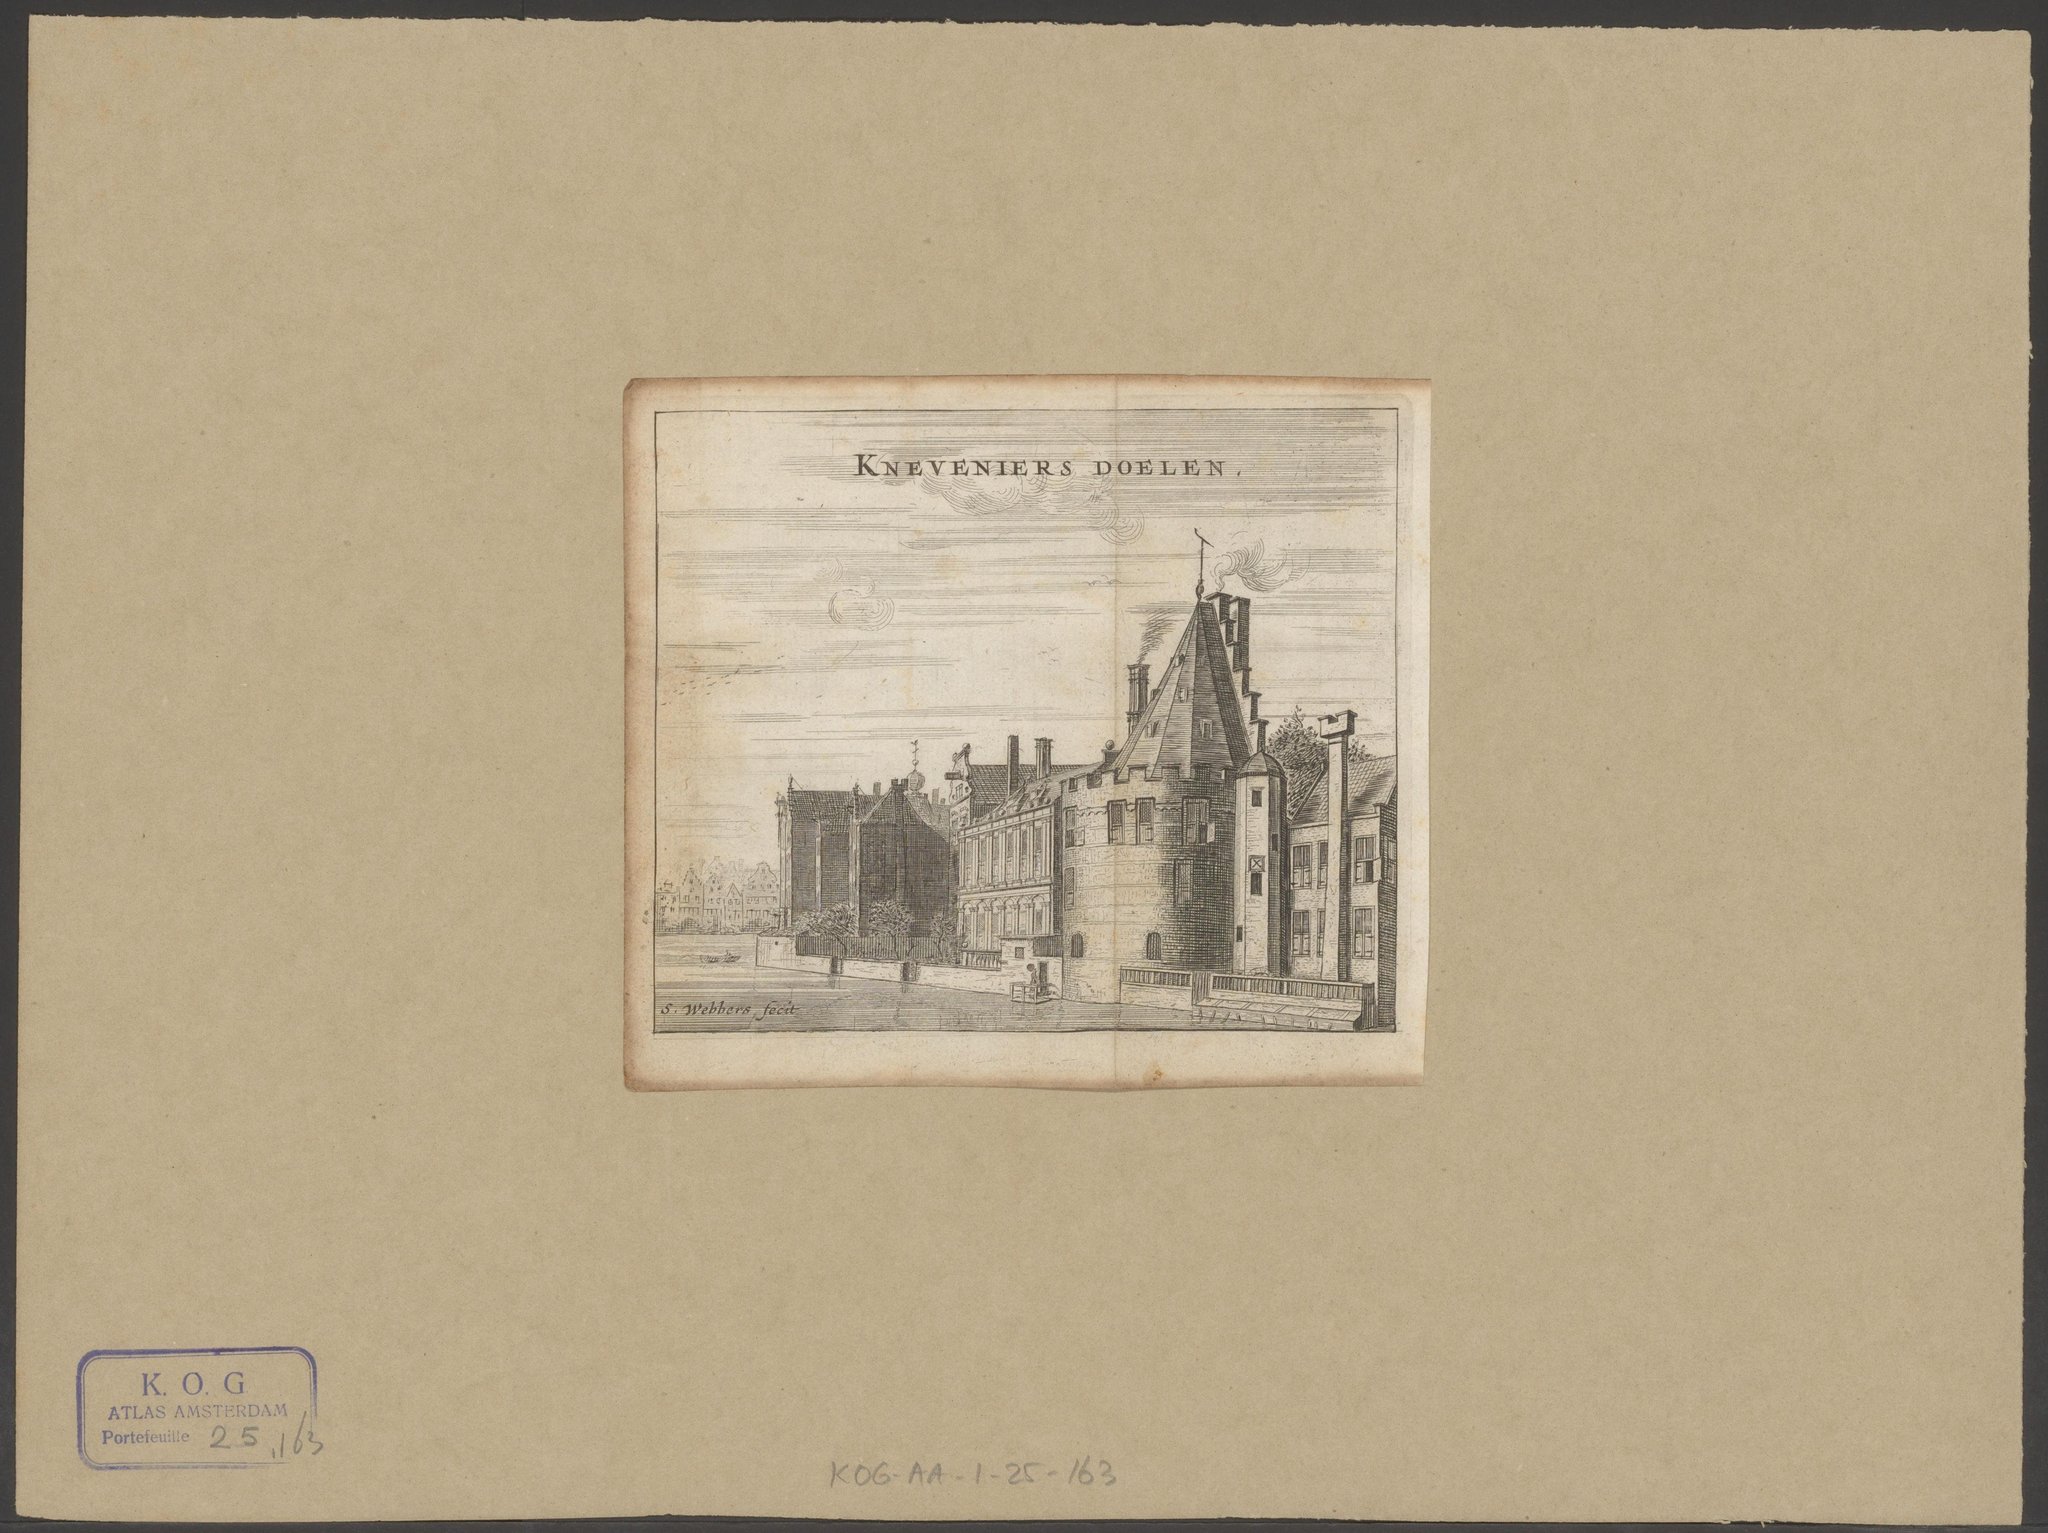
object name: book illustration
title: Kneveniers Doelen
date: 1664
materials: paper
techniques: engraving, etching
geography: amsterdam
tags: towers ~ fortified city, city-walls, land forces (+ citizen soldiery, civil guard, citizen militia), canals, waters (in city) (+ city(-scape) with figures, staffage)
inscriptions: collector's mark: ‘25.163’ Lugt 1641b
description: Huidige staat van prent ook gebruikt in: Fockens, Melchior. Beschrijving Der wijdt-vermaarde Koop-stadt Amstelredam, Van haar eerste beginselen, zedert den Jare 1203. oude Voorrechten, verscheyde Vergrootingenoude Voor-rechten, en verscheyde Vergrootingen (…). 3de druk. Amsterdam: Marcus Willemsz. Doornick, 1664. En in: Zesen, Philipp von. Beschrybung der Weidtberuhmde Kauf-Stadt Amstelredam / Beschreibung der Stadt Amsterdam darinnen von derselben ersten ursprunge bis auf gegenwartigen zustand (…). Amsterdam: Marcus Willemsz. Doornick, 1664. Eerste bekende staat van prent (linksboven genummerd: 34) ook gebruikt in: Fockens, Melchior. Beschrijvinge Der wijdt-vermaarde Koop-stadt Amstelredam, Van hare eerste beginselen, oude Voor-rechten, en verscheyde Vergrootingen (…). 1e druk. Amsterdam: Marcus Willemsz. Doornick, 1662. En in: Fockens, Melchior. Beschrijvinge Der wijdt-vermaarde Koop-stadt Amstelredam, Van hare eerste beginselen, oude Voor-rechten, en verscheyde Vergrootingen (…). 2de druk. Amsterdam: Marcus Willemsz. Doornick, 1662. Derde bekende staat (met toevoeging Franse titel) ook gebruikt in: Domselaer, Tobias en Isaac Commelin. Beschryvinge van Amsterdam : haar eerste oorspronk uyt den huyze der heeren van Aemstel en Aemstellant (…). 6 dln. Amsterdam: Marcus Willemsz van Doornick, 1665. Vierde bekende staat (rechtsboven genummerd: 47) ook gebruikt in verschillende latere zeventiende- en achttiende-eeuwse publicaties.